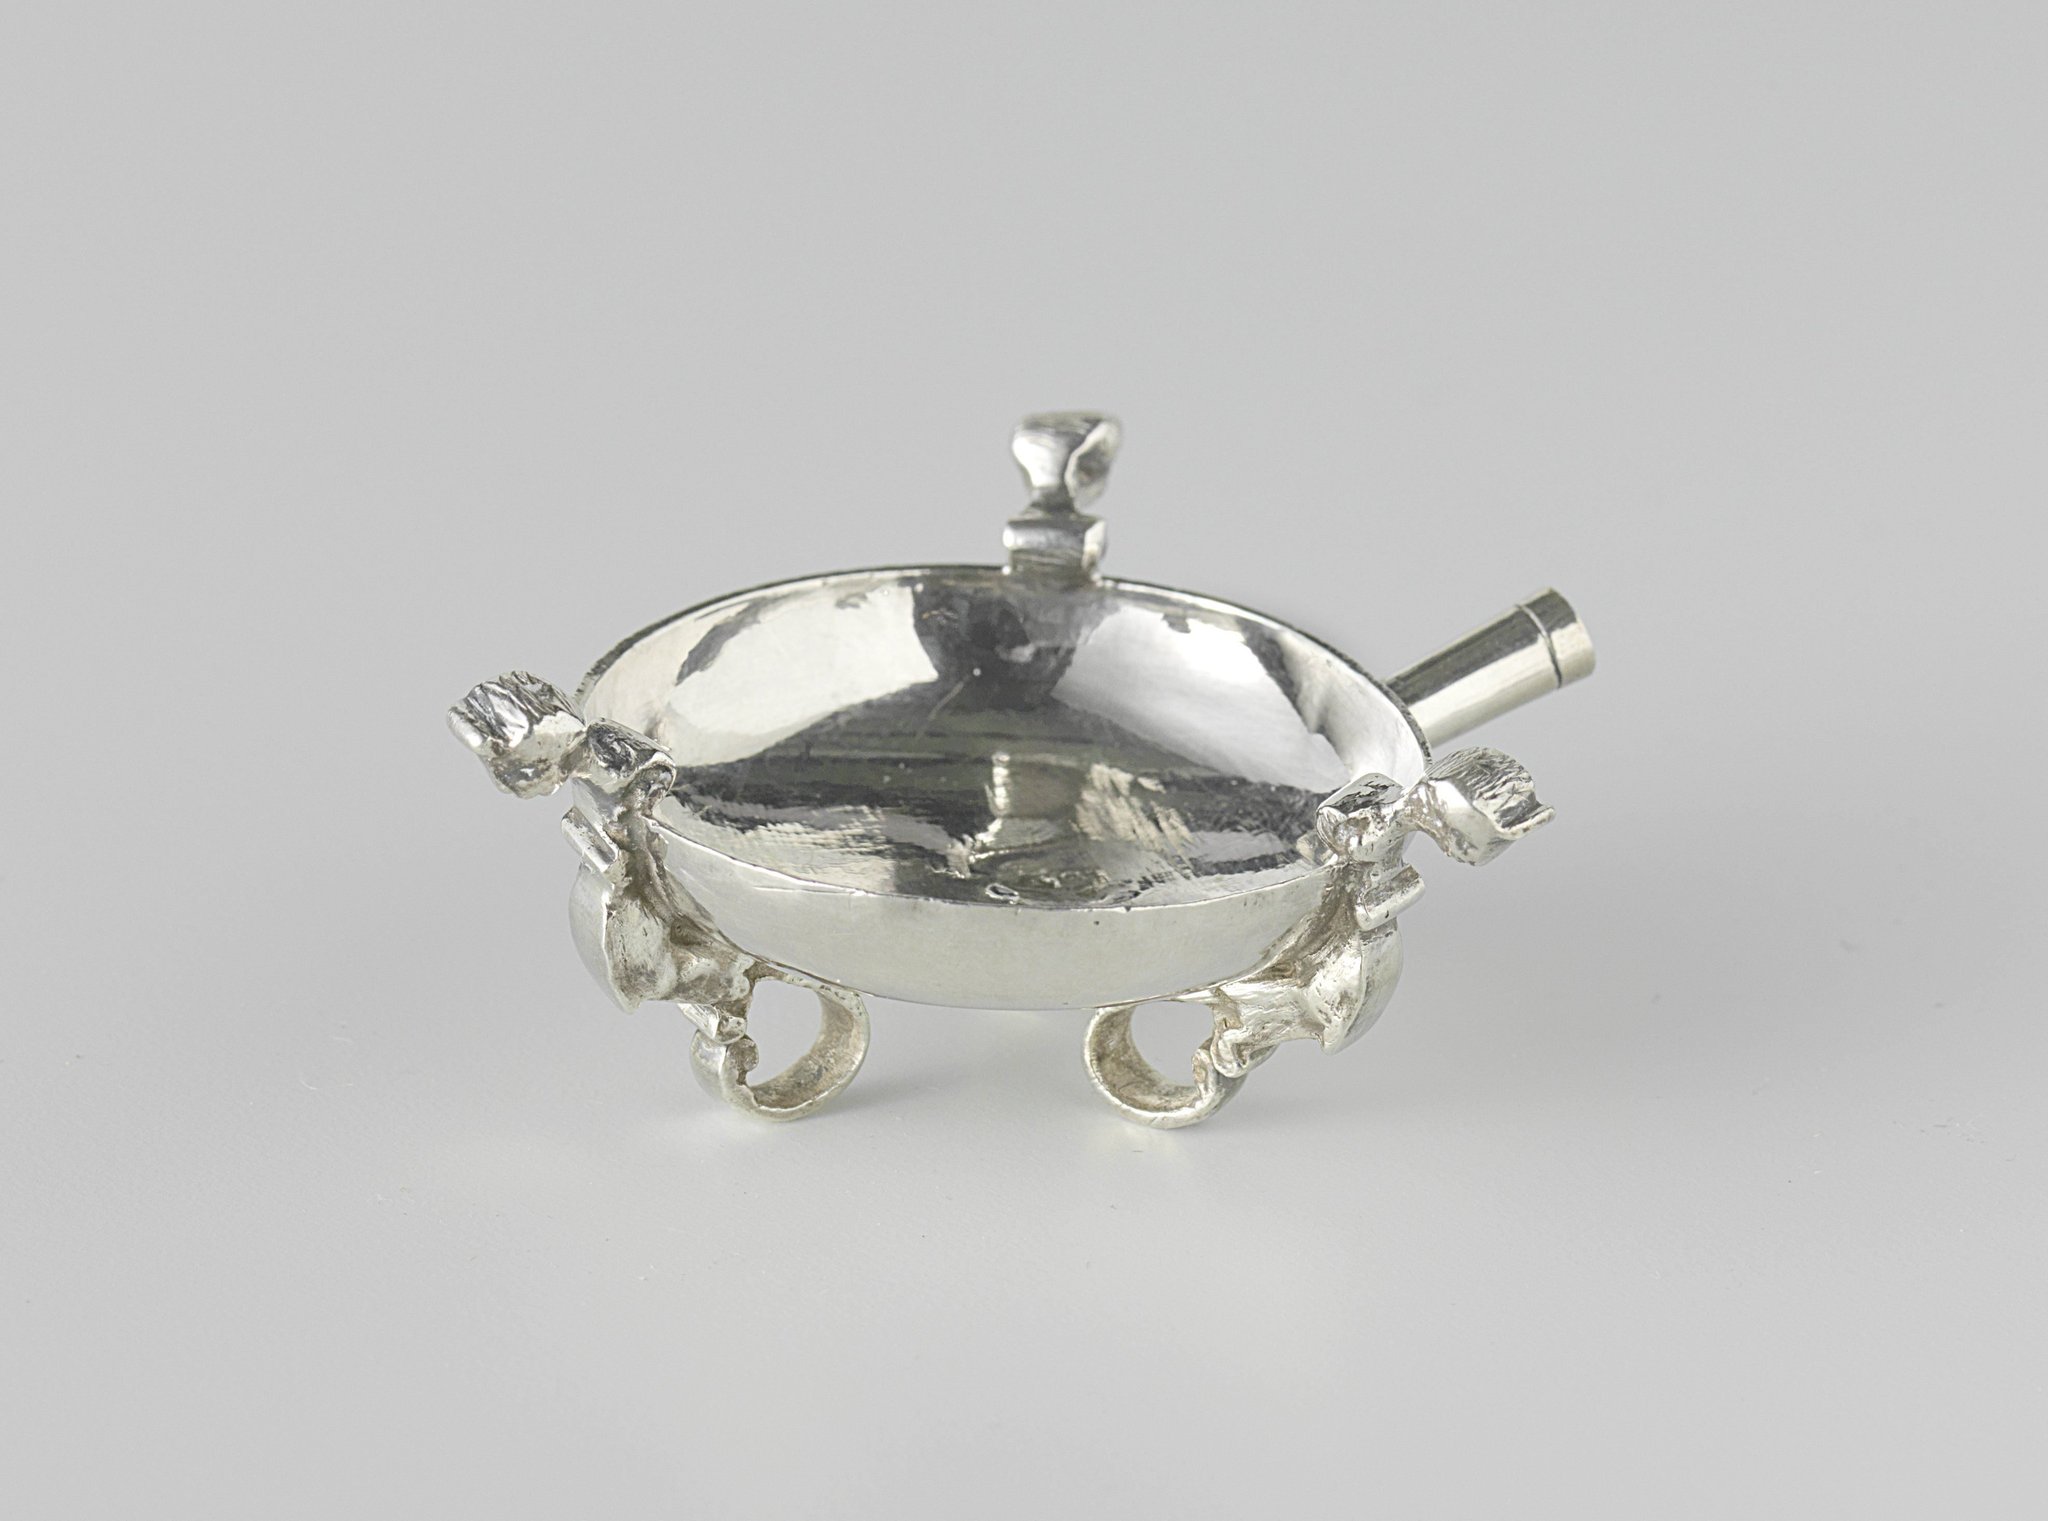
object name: miniature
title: Tabakskomfoor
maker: pieter van somerwil (i)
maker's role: silversmith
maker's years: 1706-1753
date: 1730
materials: silver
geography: amsterdam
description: Rond, ondiep tabakskomfoor op drie poten die tot aan de rand van de bak doorlopen en daar uitlopen in geprofileerde knoppen. Onder de bak zijn de poten naar binnen gebogen. Het komfoor heeft een aanzet voor een steel die echter ontbreekt. Het komfoor is gemerkt: stk.= Amsterdam, mt.= toegeschreven aan Pieter van Somerwil I en een bijltje.